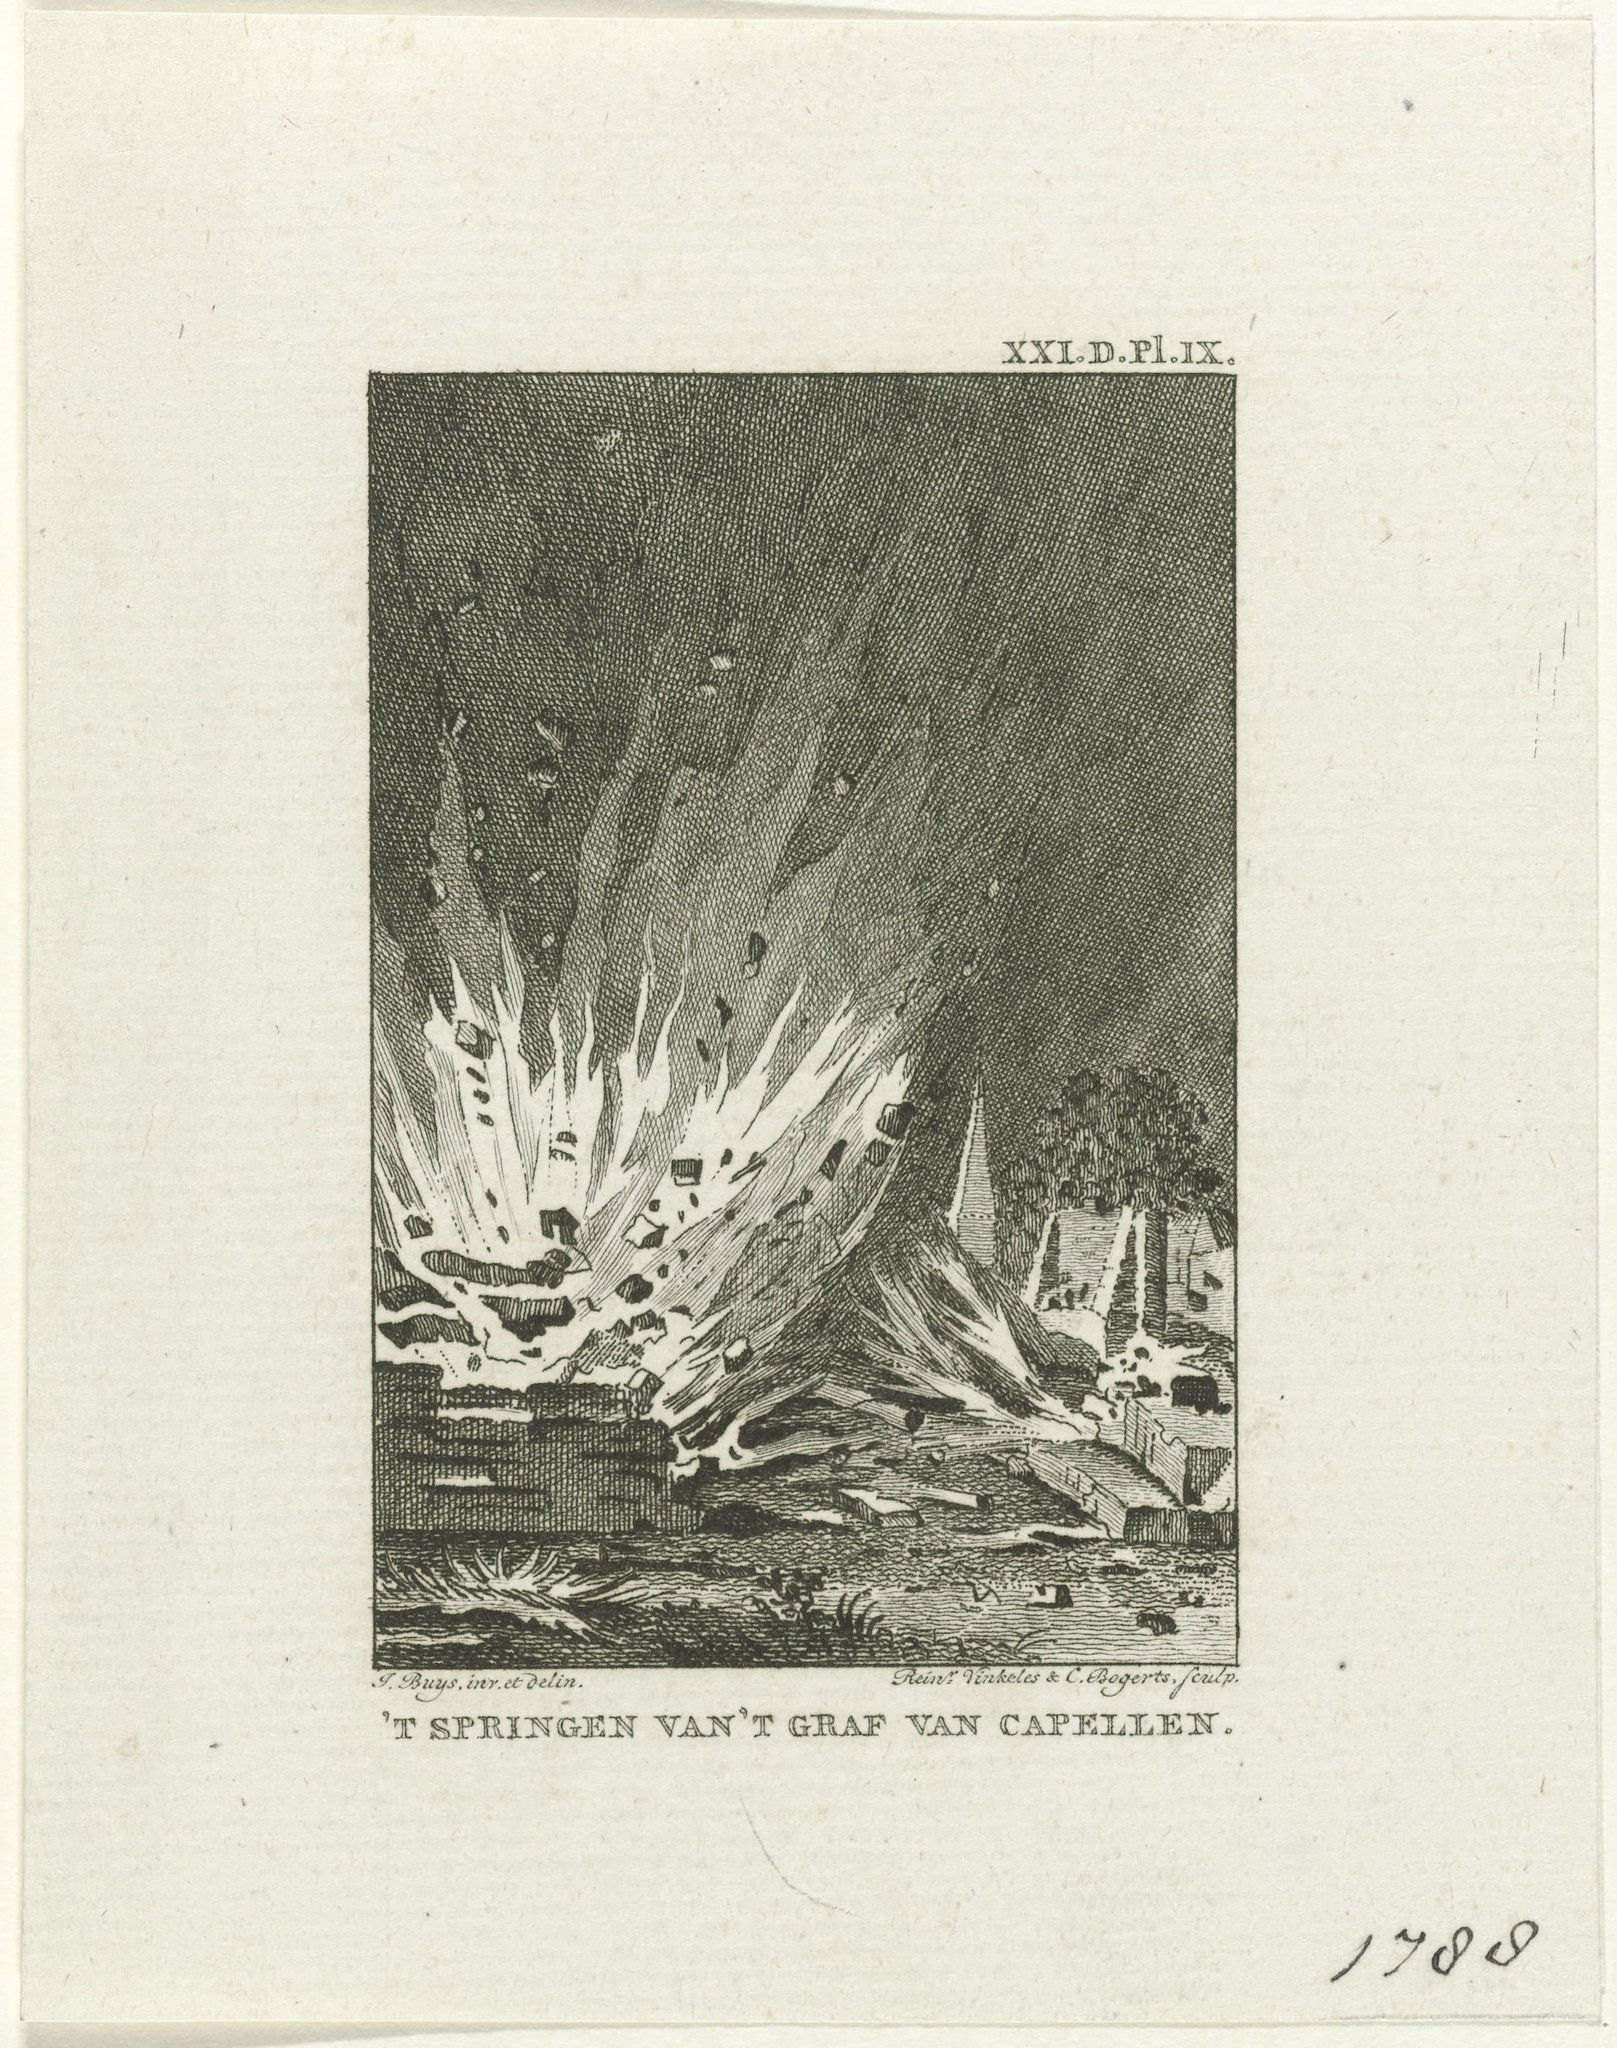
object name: print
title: Opblazen van de begraafplaats van de familie Van der Capellen, 1788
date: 1788-1795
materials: paper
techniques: engraving, etching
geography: northern netherlands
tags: politician, joan derk van der capellen tot den pol, bomb-outrage, grave-building, monumental tomb, patriots (1780-1795)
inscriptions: collector's mark: Lugt 2228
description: Gebruikt als illustratie in: J. Fokke, Geschiedenissen der Vereenigde Nederlanden voor de vaderlandsche jeugd, Johannes Allart, Amsterdam 1783-1795, 25 delen, dl. 21, pl. 9.